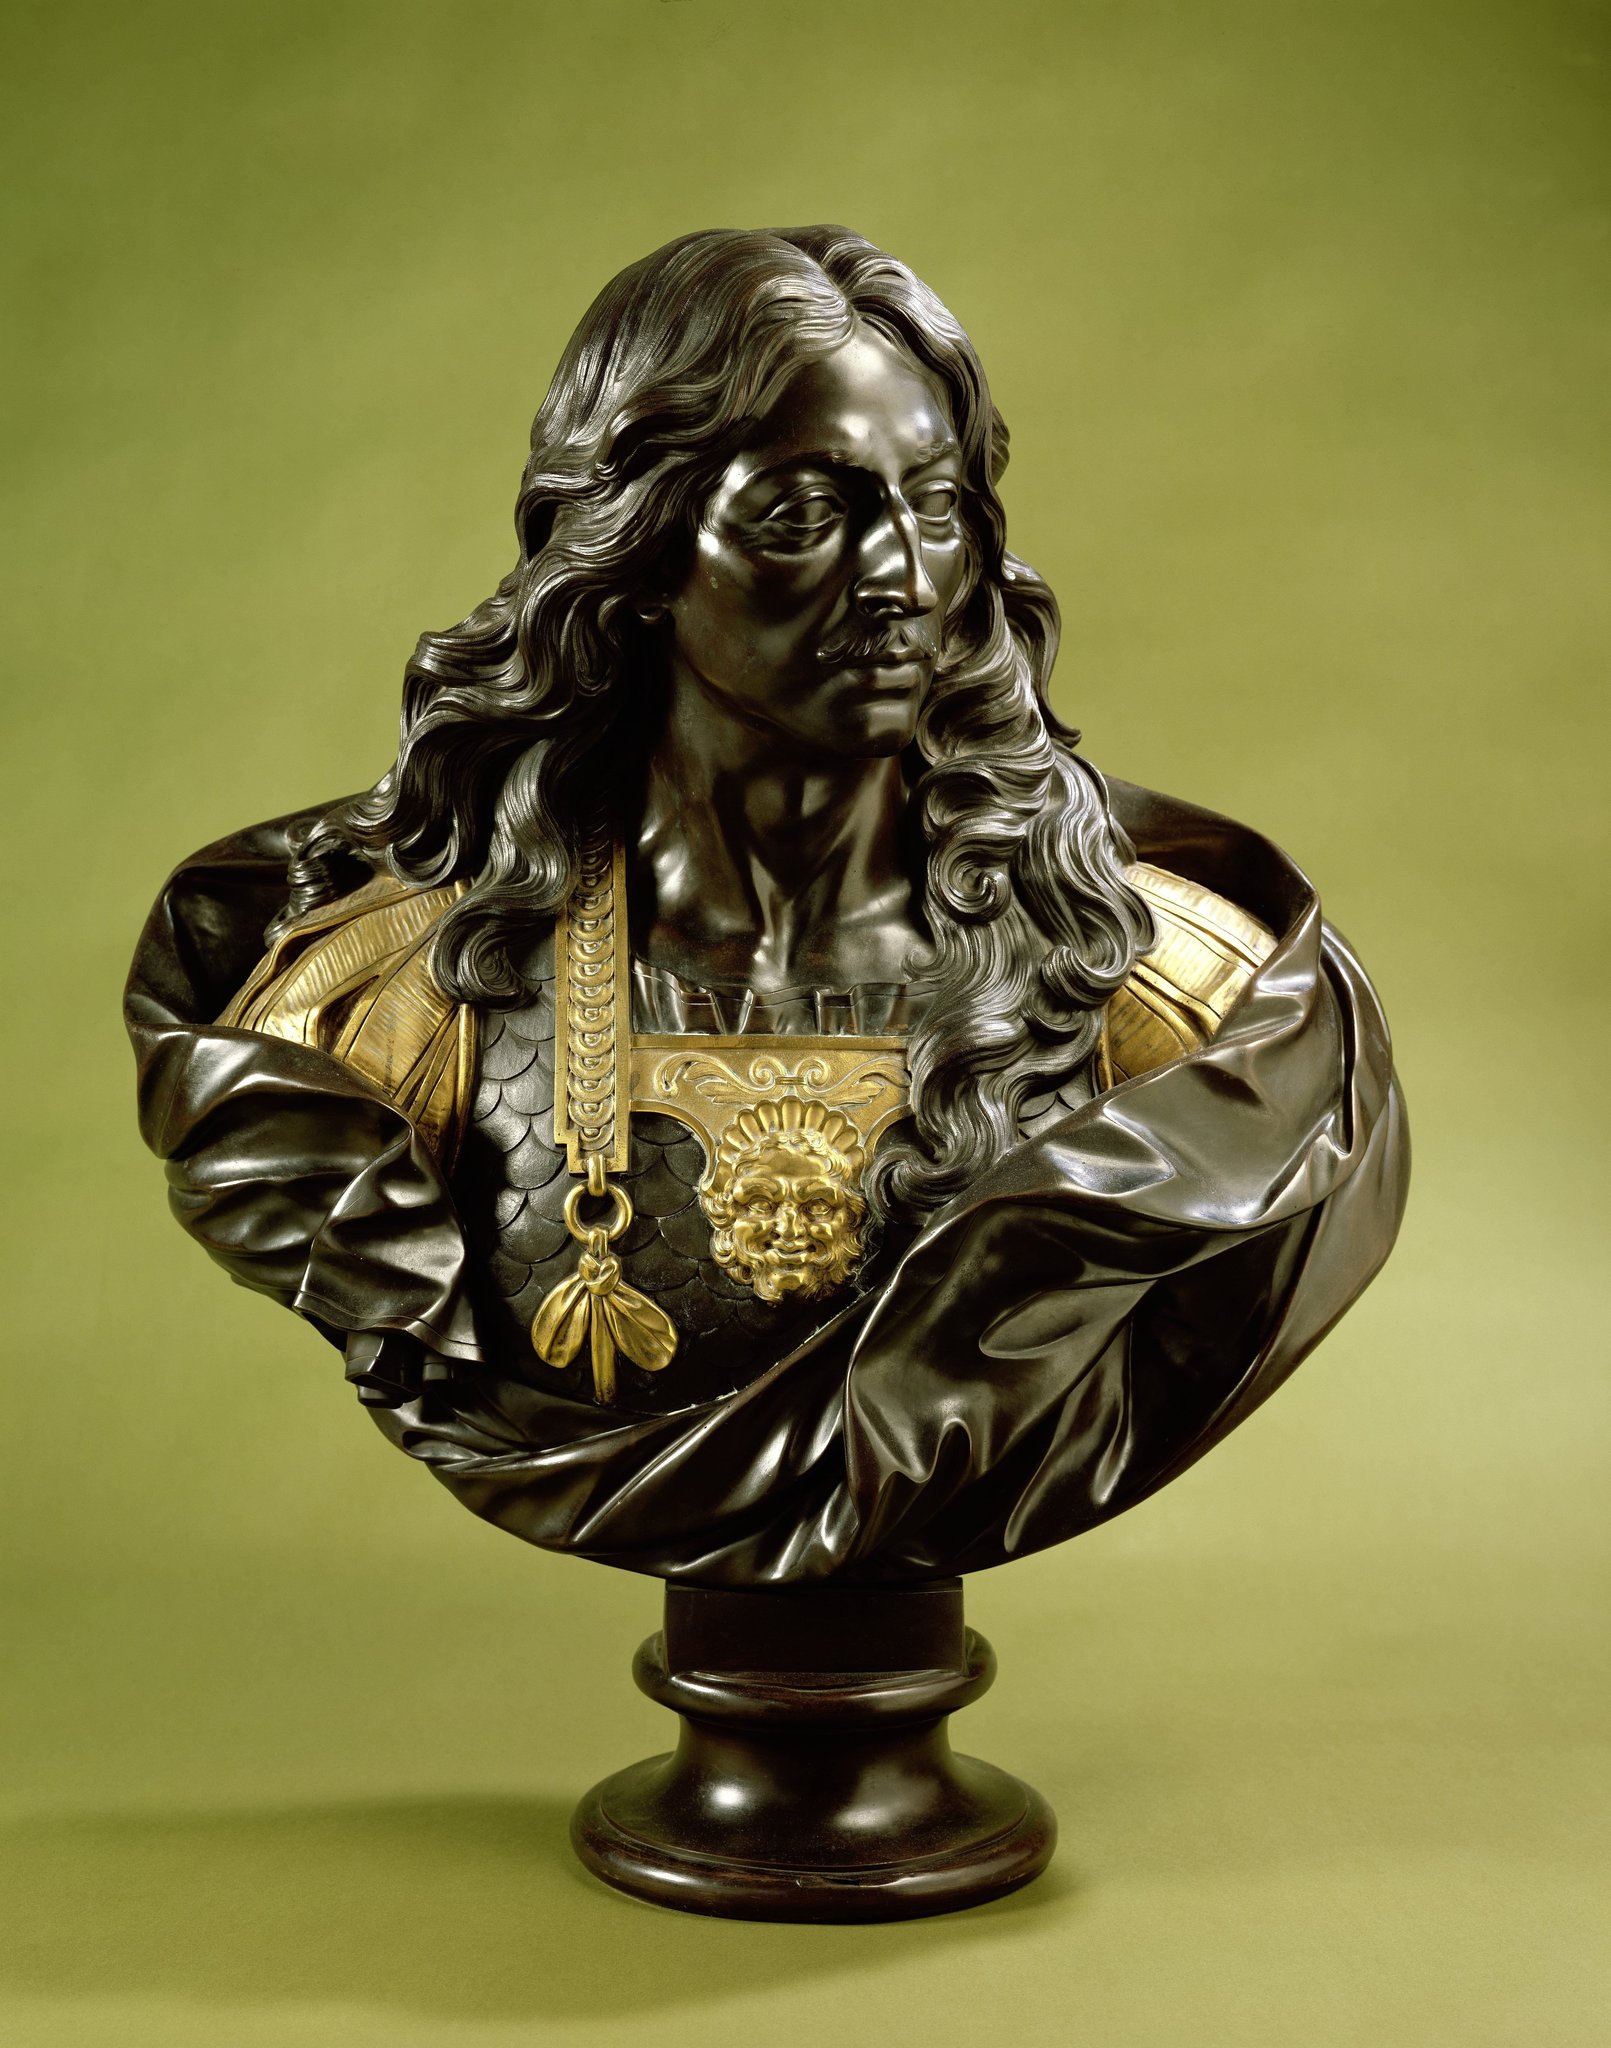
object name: sculpture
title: Borstbeeld van Louis II de Bourbon, prins van Conde, maarschalk van Frankrijk, bijgenaamd Le Grand Conde (1621-1686)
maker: jérôme derbais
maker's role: sculptor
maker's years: 1668-1715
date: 1695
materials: bronze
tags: france